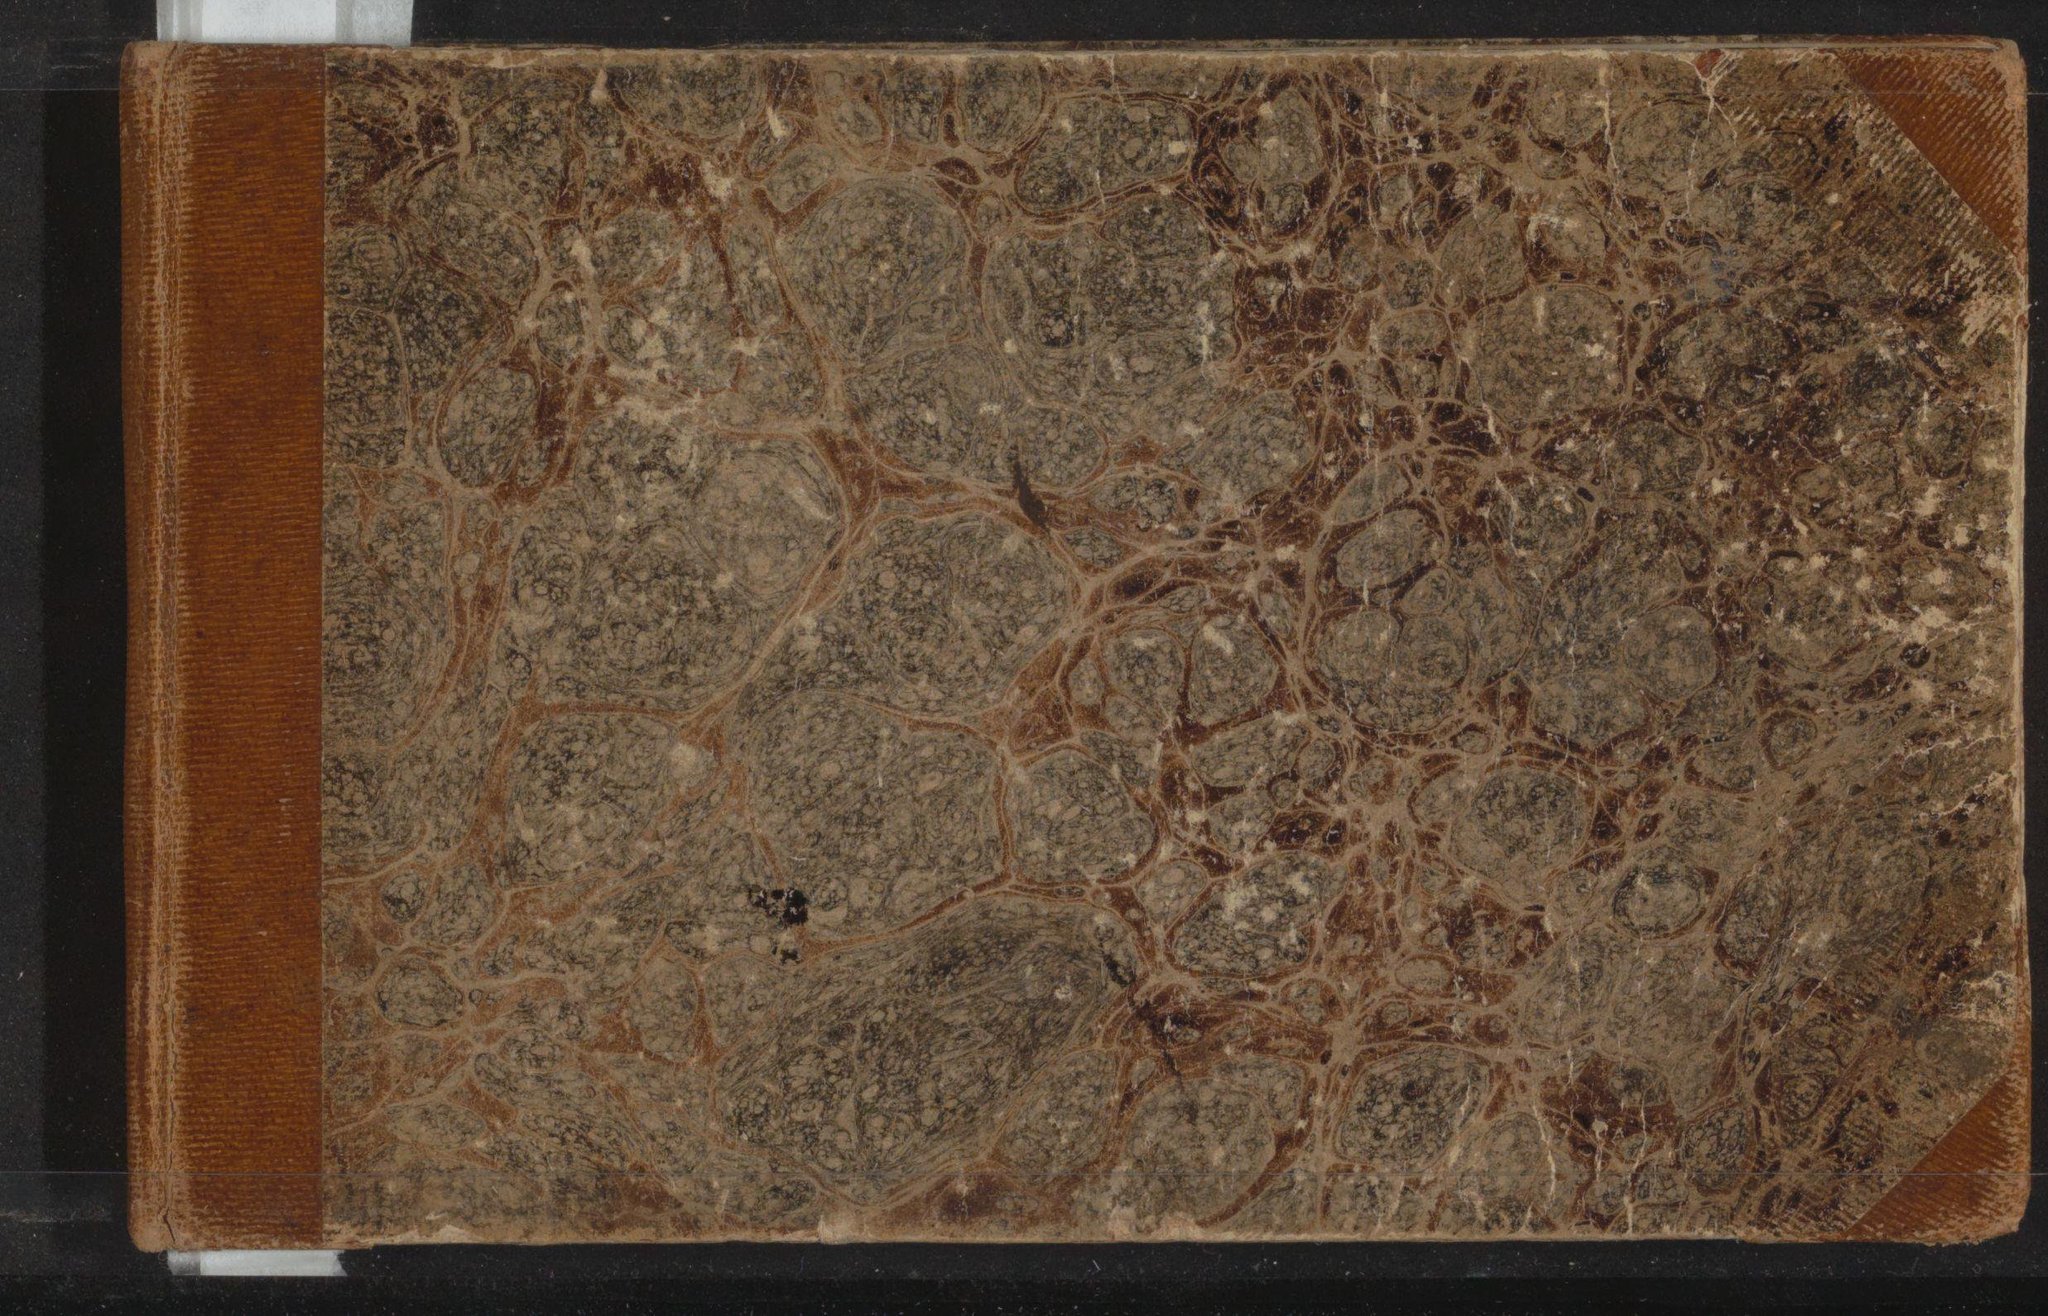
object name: sketchbook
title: Schetsboek met 37 bladen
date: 1839-1840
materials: cardboard, paper, pencil, watercolor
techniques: brush, marbling, pen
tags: landscapes, animals, monk(s), friar(s)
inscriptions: retailer's mark: ‘Magazijn/ van/ Schilder-Teeken- en Kantoorbehoeften,/ Gravuren & Steendrukplaten./ van/ W.J. van Oosterzee,/ Hoogstraat Hoek der Hoofdsteeg J 427/ te/ Rotterdam’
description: Schetsboek bestaande uit 37 bladen met voornamelijk landschappen, figuurstudies en dieren. Het schetsboek bevat ook enkele portretkoppen van monniken die Tavenraat maakte met Willem Hendrik Schmidt, studies van een vrouw en monnik door Schmidt en studies van paarden door Charles Rochussen.